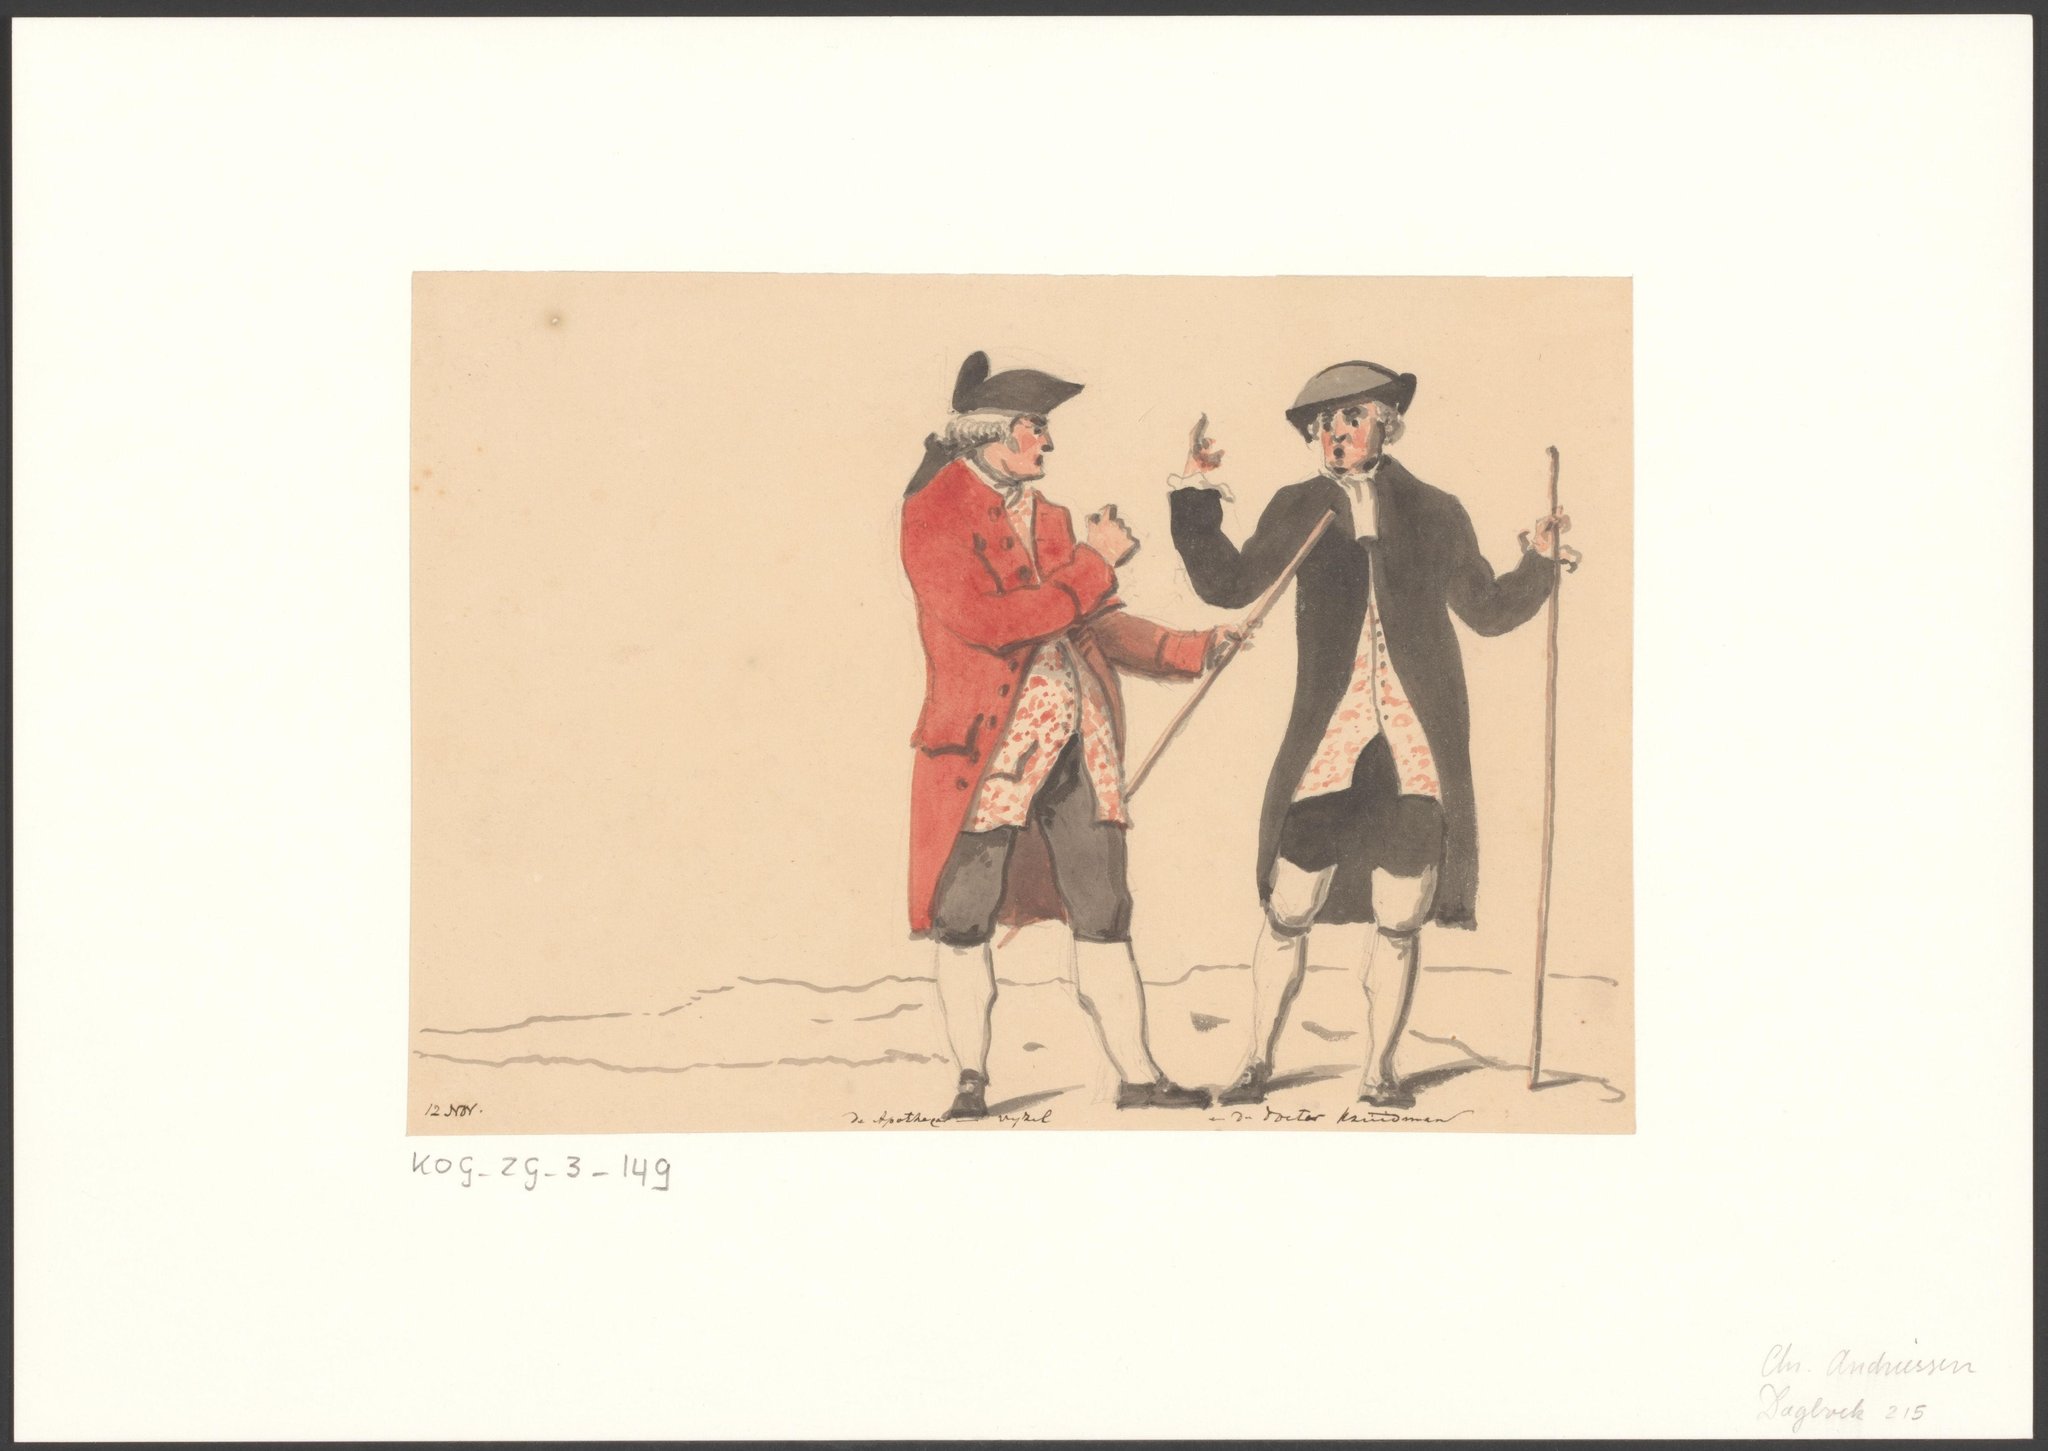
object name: drawing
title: Twee hoofdfiguren uit de opera Doktor und Apotheker van Karl Ditter von Dittersdorf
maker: christiaan andriessen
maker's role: draughtsman, print maker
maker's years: 1775-1846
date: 1806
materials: ink, paper, pencil, watercolor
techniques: brush, pen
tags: theatre, theatrical performance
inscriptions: inscription: ‘12 nov. de apotheker vijzel en de docter kruidman’, signature: ‘J Andriessen’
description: De twee hoofdfiguren uit de opera Doktor und Apotheker van Karl Ditter von Dittersdorf, die in 1786 in Wenen in première ging.